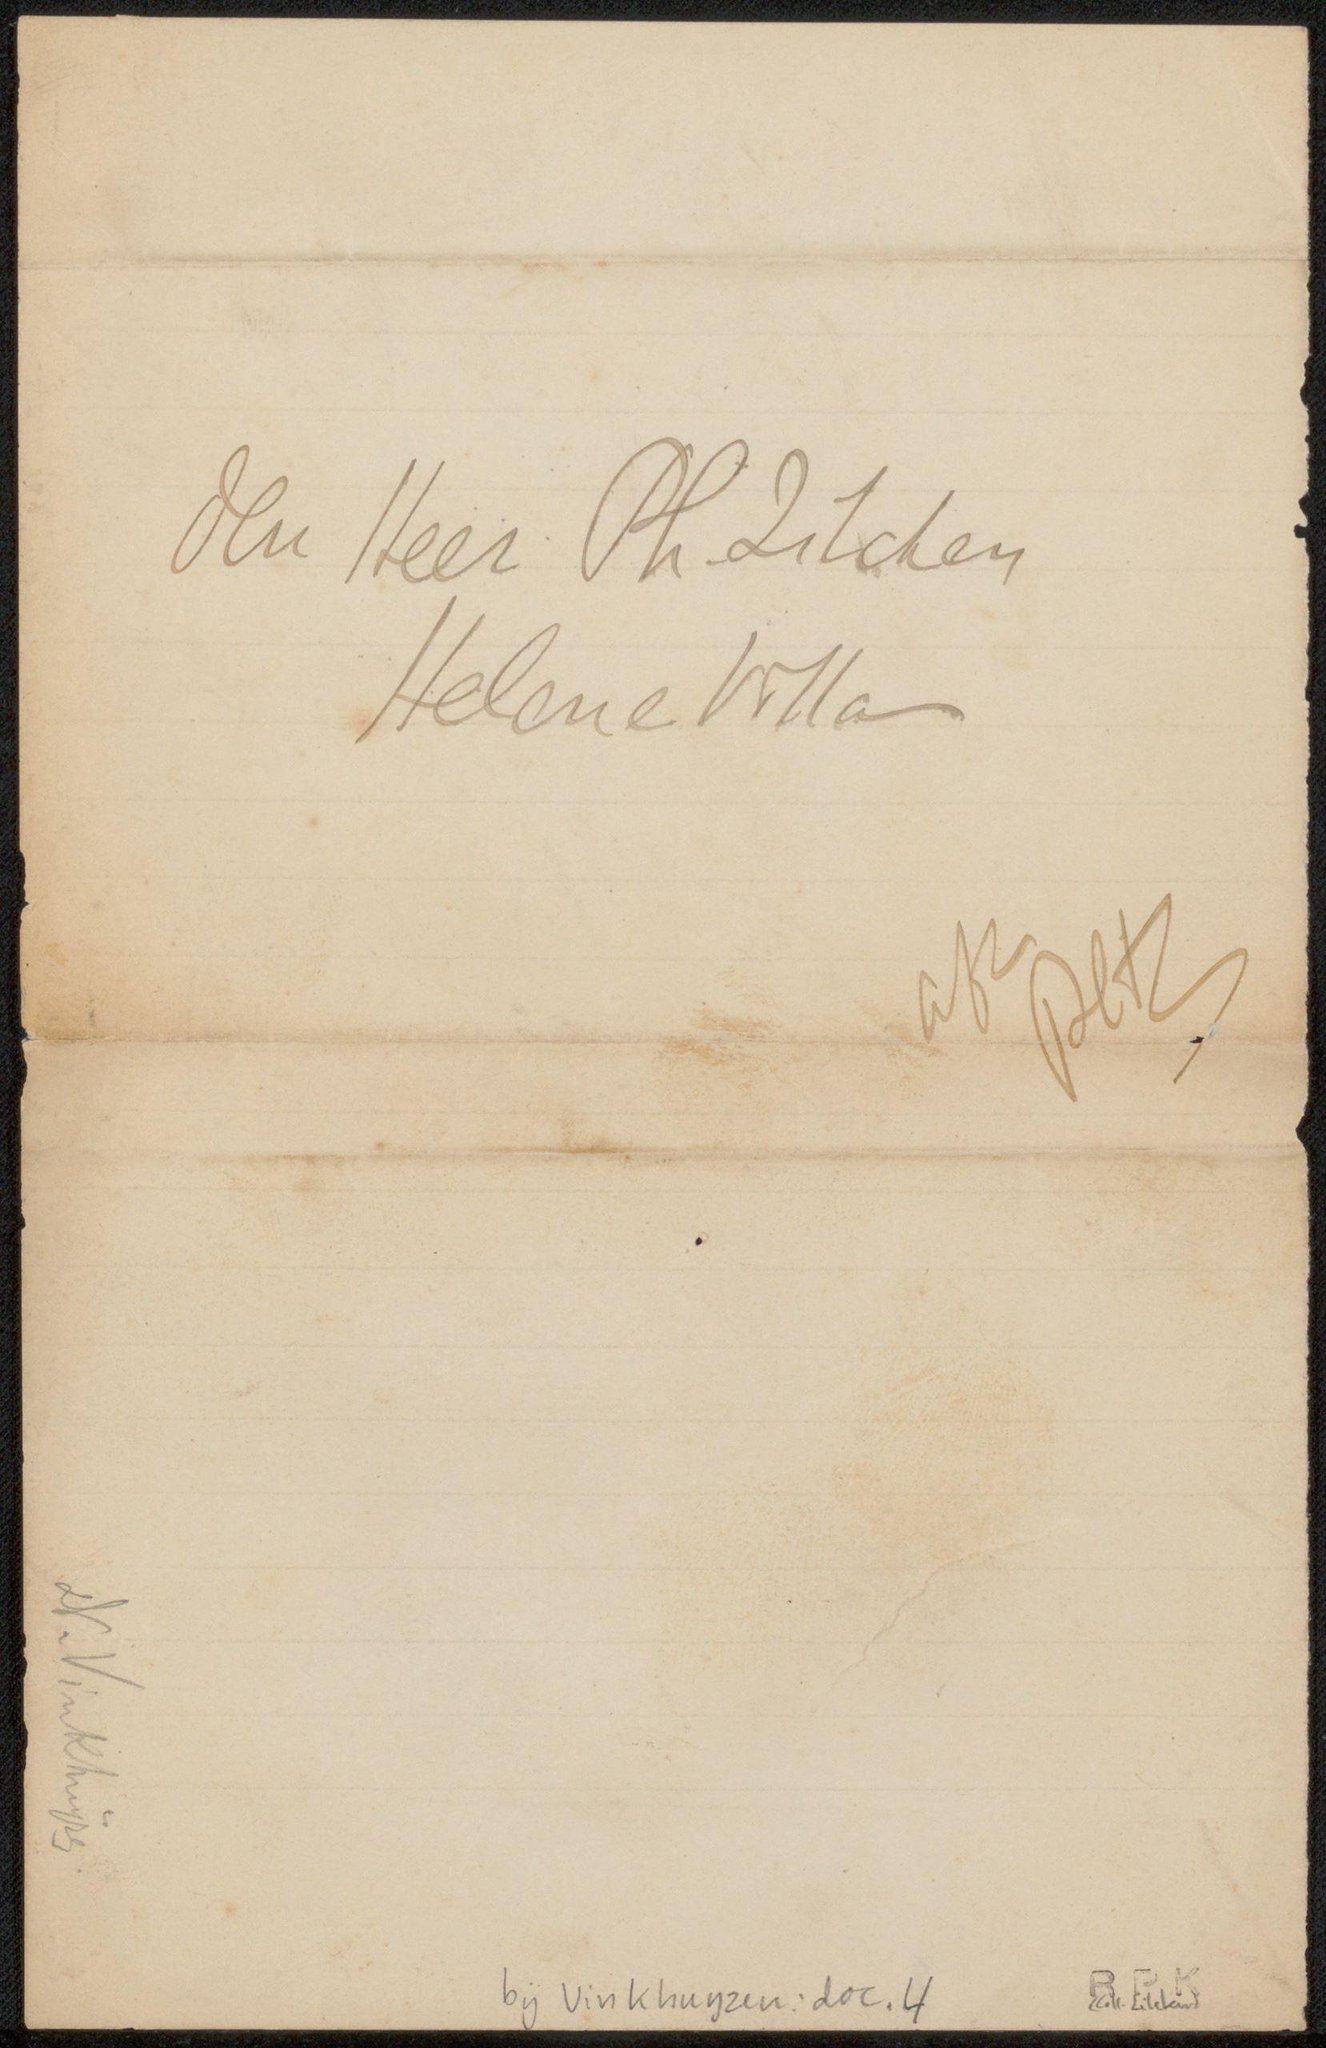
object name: aantekening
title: Aantekening uit archief Philip Zilcken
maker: Anonymous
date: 1867-1930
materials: ink, paper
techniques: pen, writing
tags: the hague, painter, draughtsman, philip zilcken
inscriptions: collector's mark: ‘RPK’